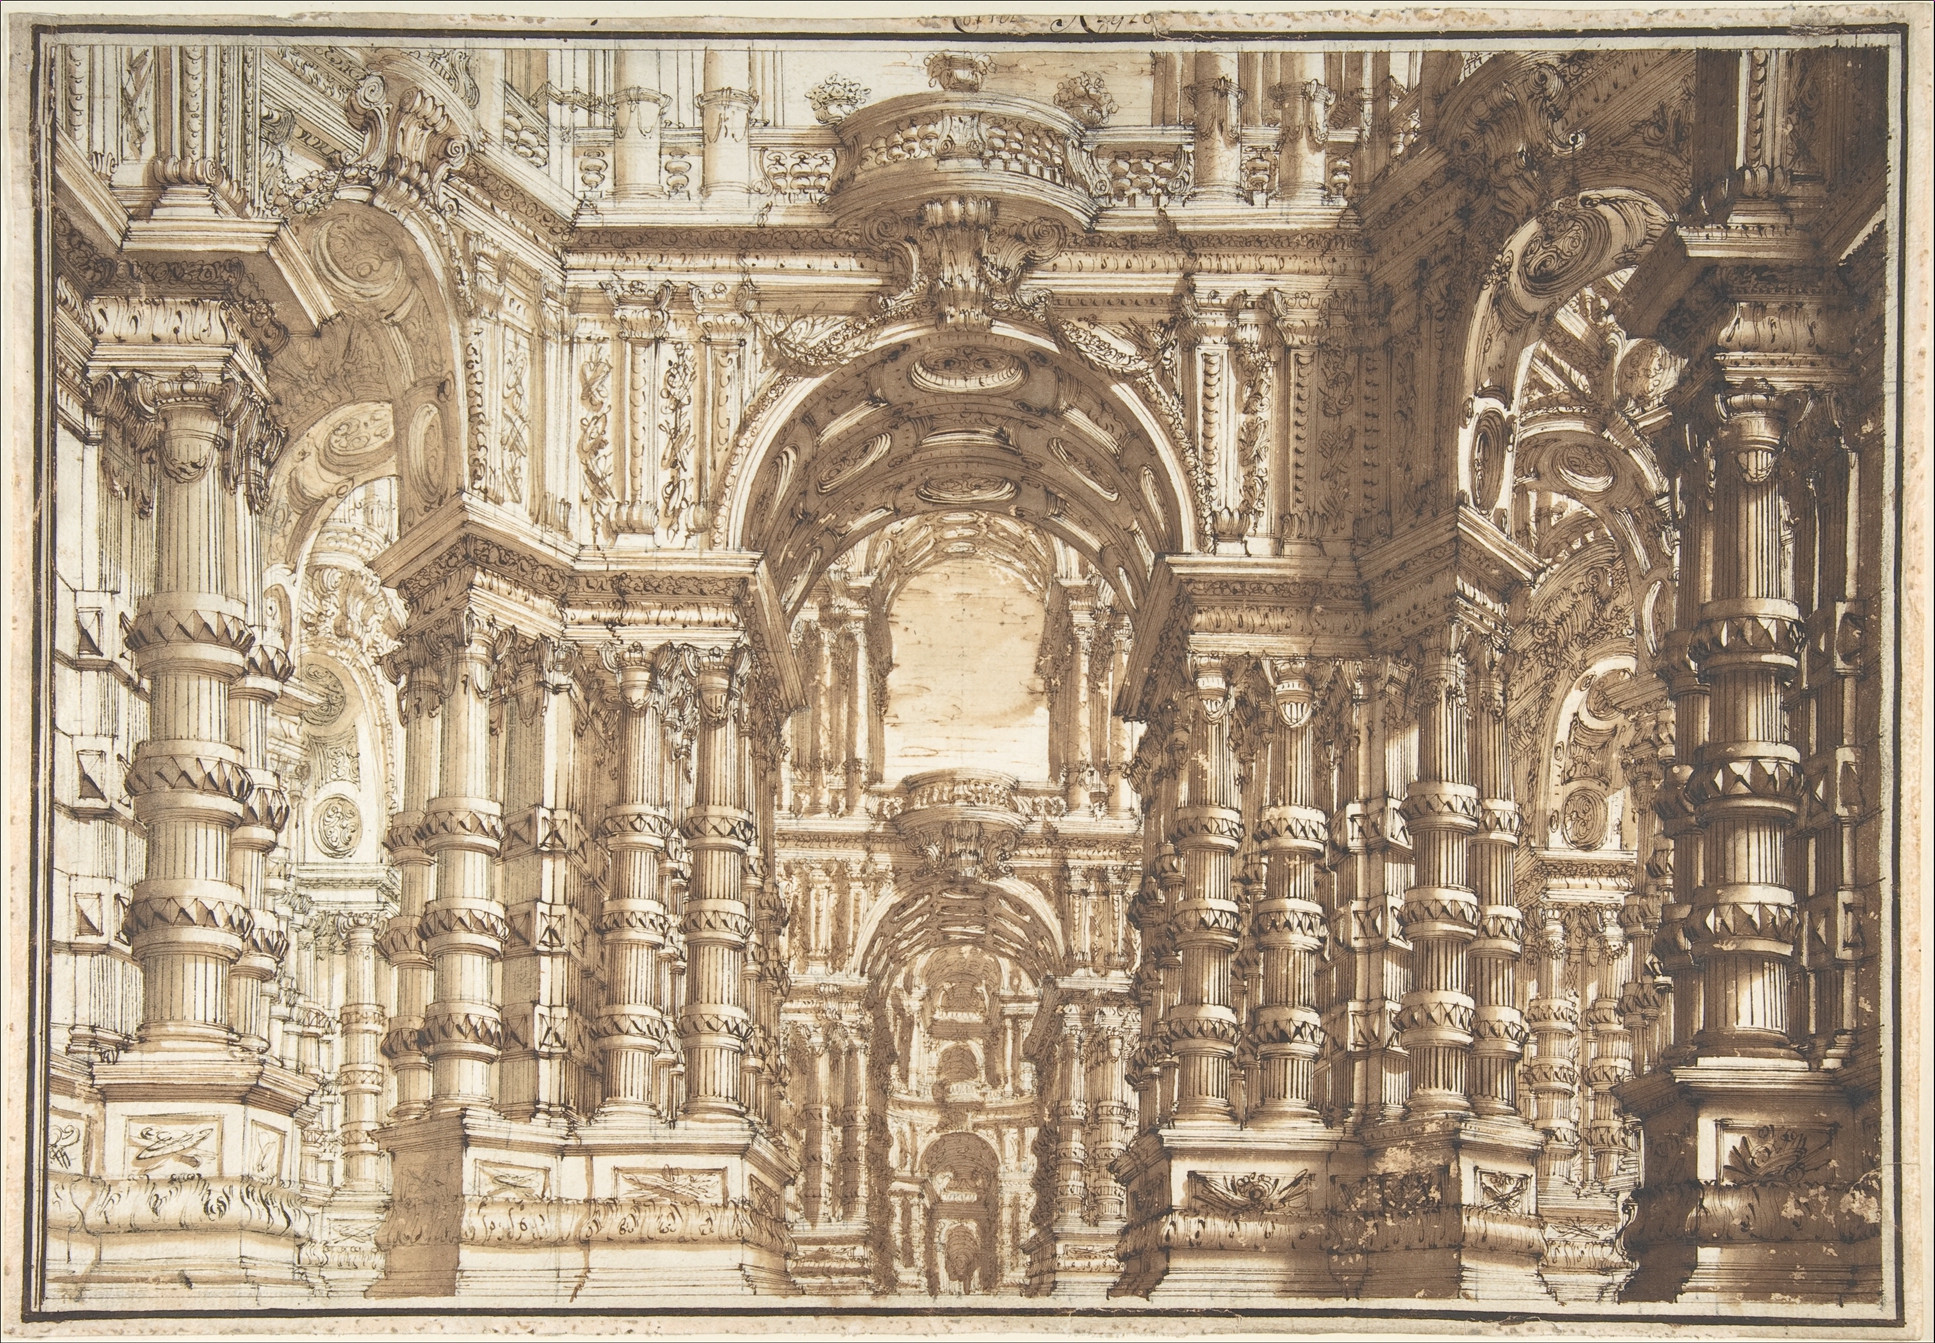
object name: drawing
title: Drawing for an Opera Set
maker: giuseppe galli bibiena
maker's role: artist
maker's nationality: italian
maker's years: 1696-1756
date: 1696-1756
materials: ink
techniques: pen, wash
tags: architecture,arches,columns